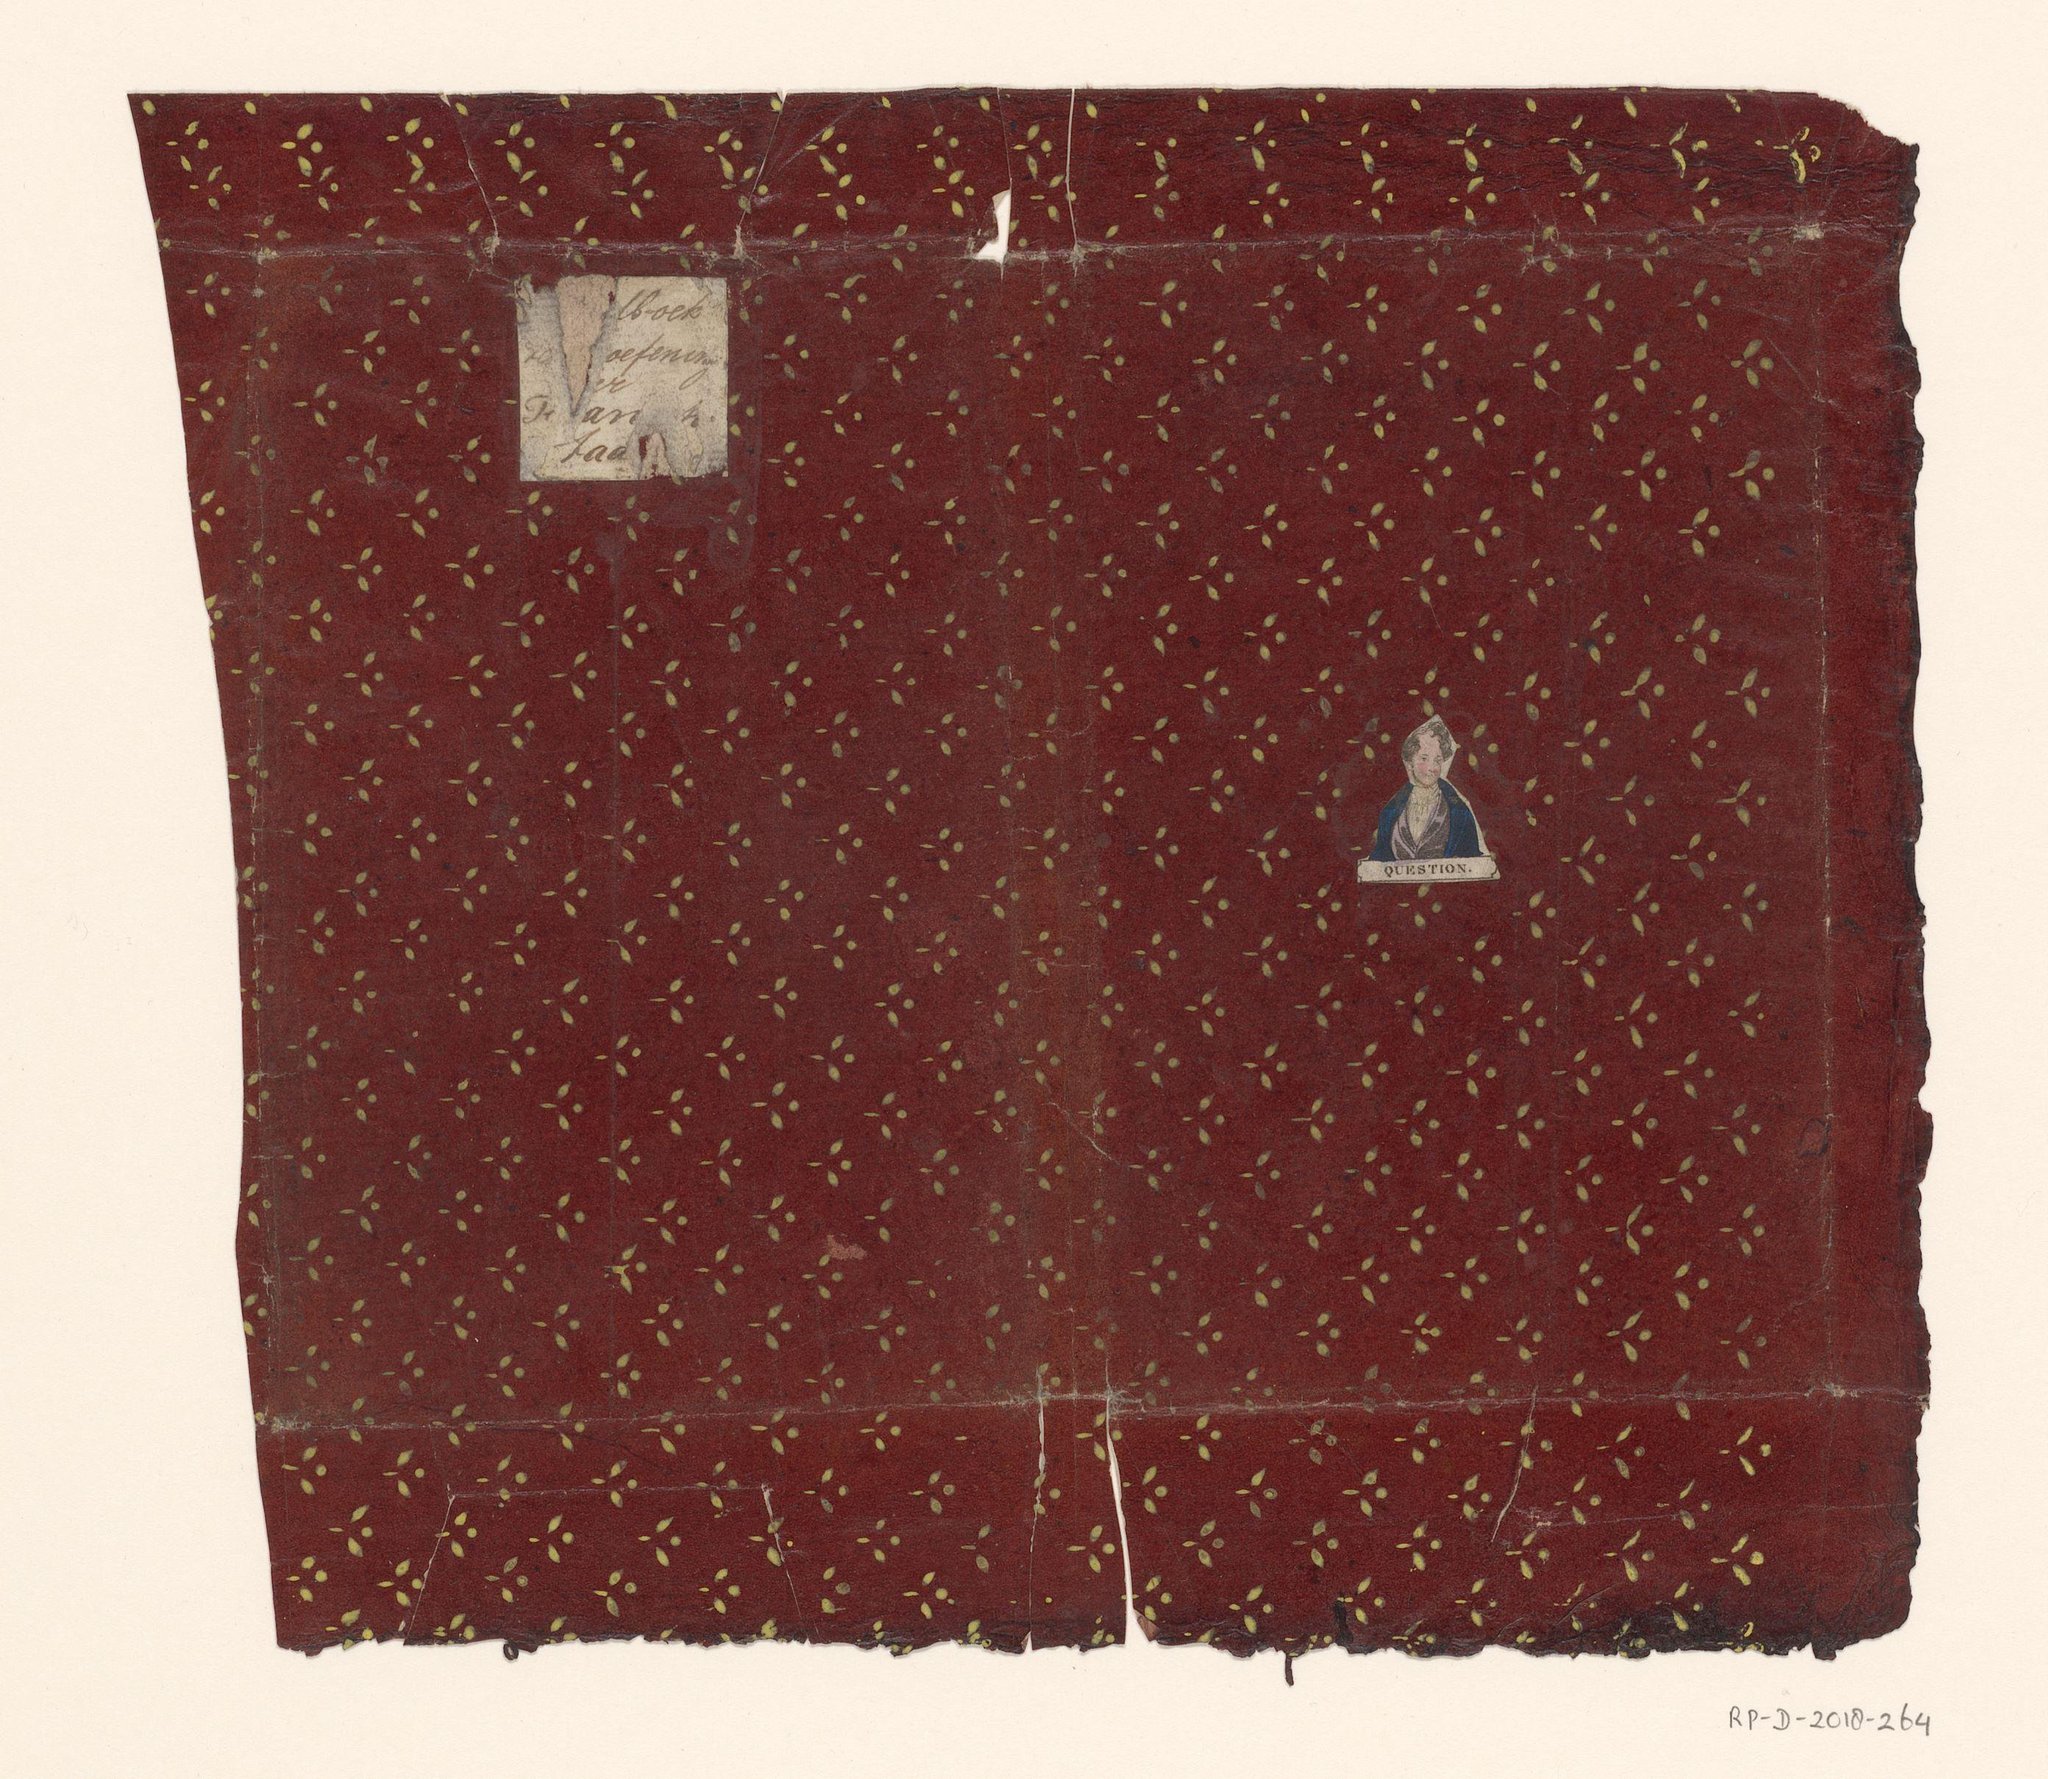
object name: wrapper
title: Blad met strooipatroon van bloemmotief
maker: Anonymous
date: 1750-1900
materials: lacquer, paper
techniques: printing block, lacquer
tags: ornament derived from plant forms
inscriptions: collector's mark: Lugt 2228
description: Blad met strooipatroon van bloemmotief. Gebruikt als omslag, met insnijdingen bij de rug. Met opgeplakt etiket met borstbeeld van een man met gedrukt opschrift 'Question' en etiket met handgeschreven opschrift: 'boek ... oefeningen'.